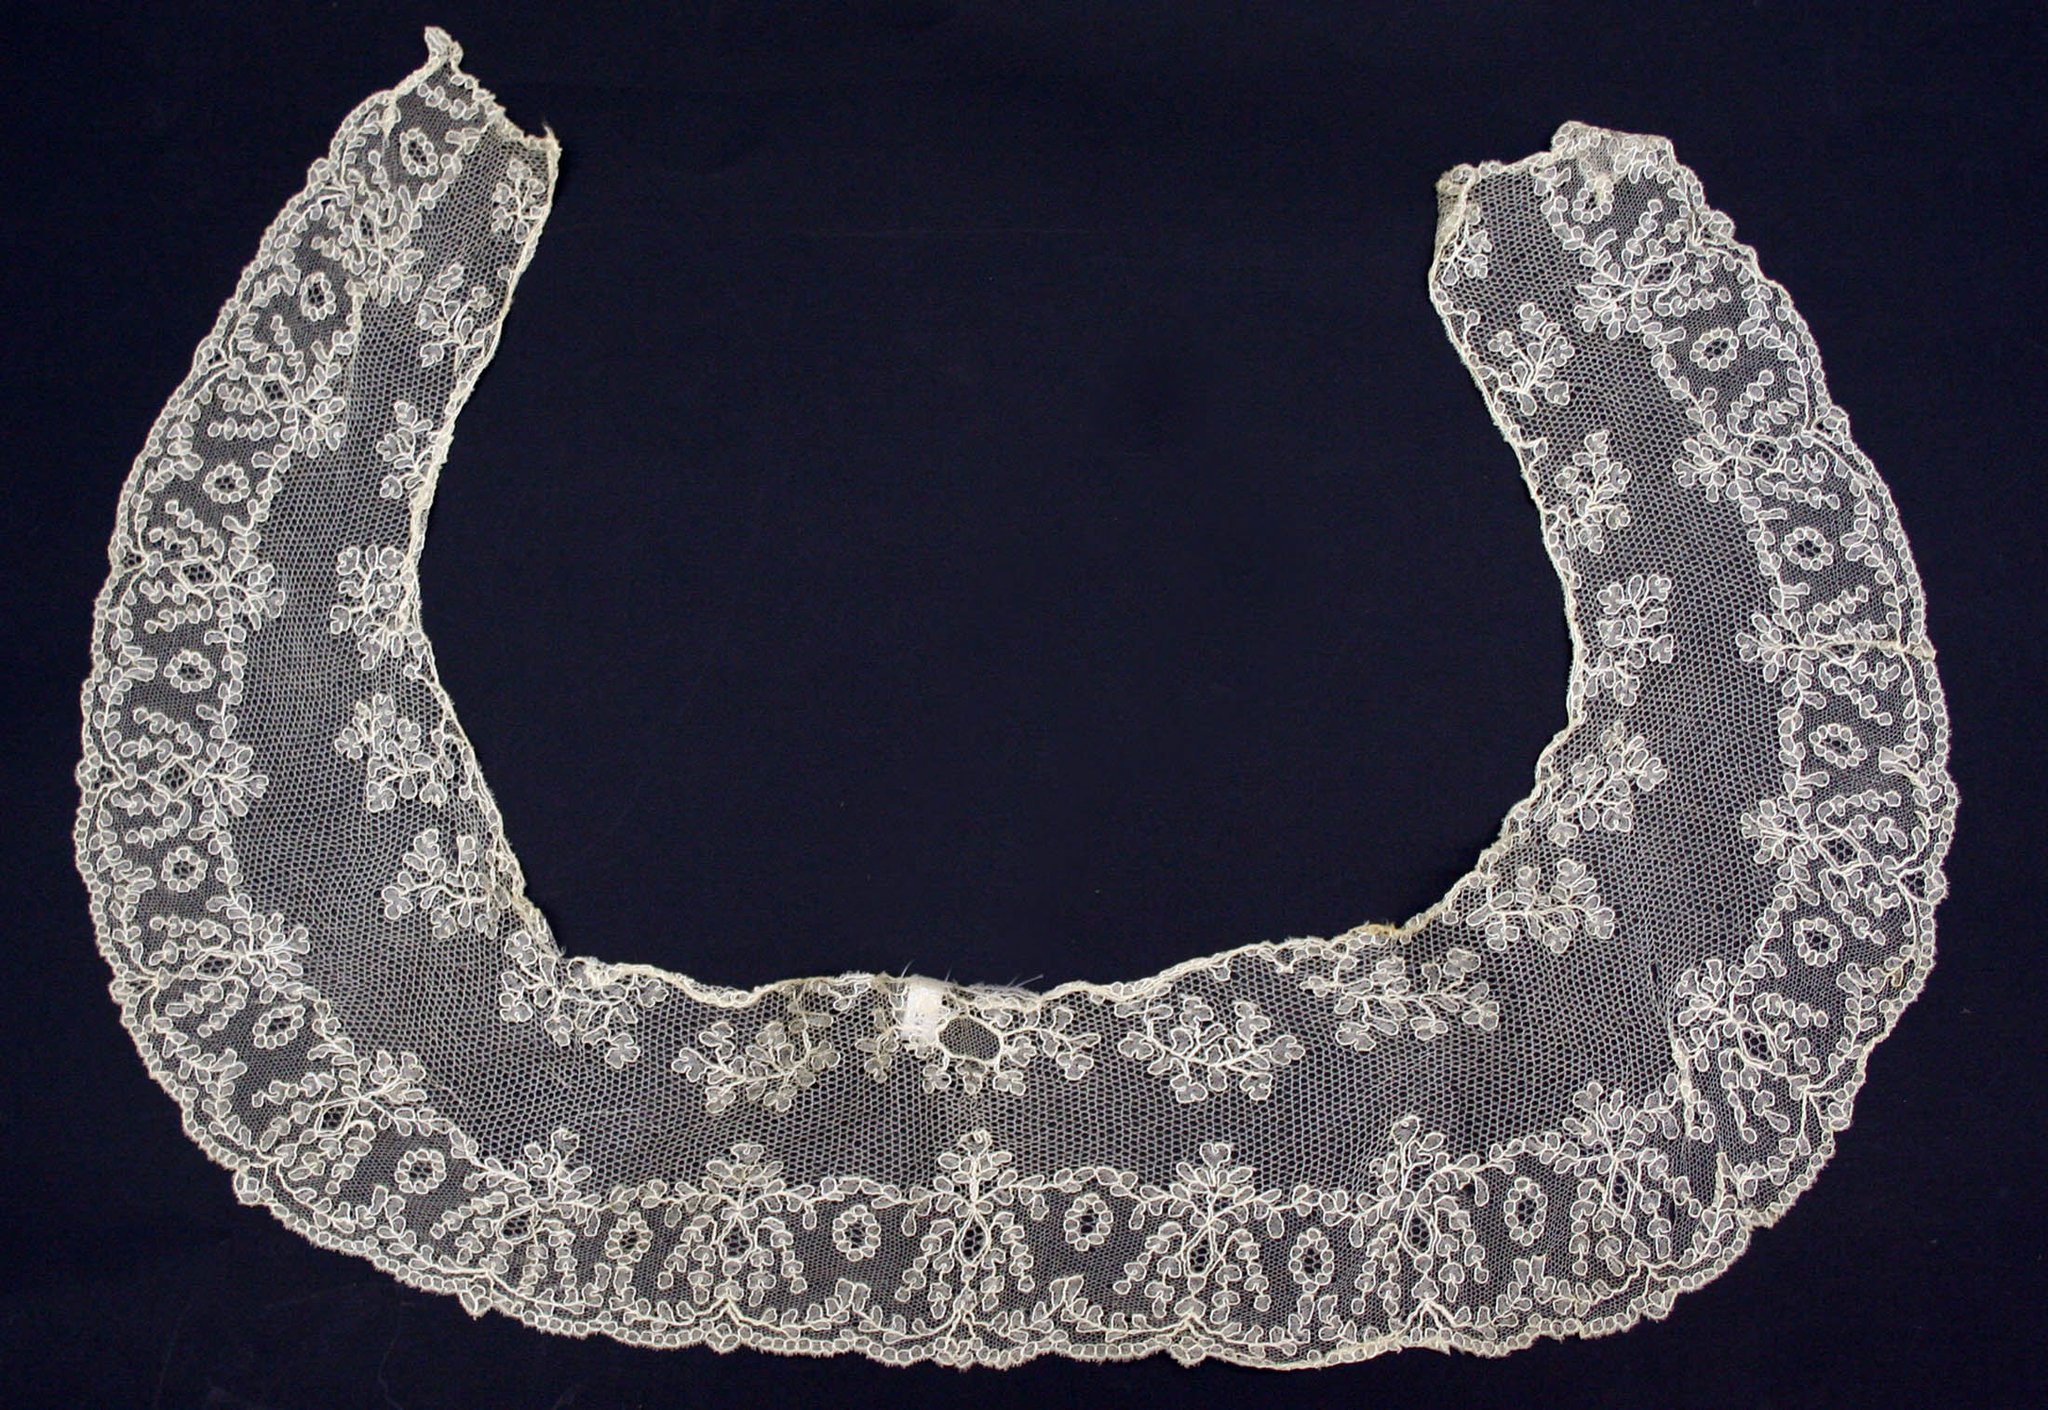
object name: bertha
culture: spanish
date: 1834-1866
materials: silk